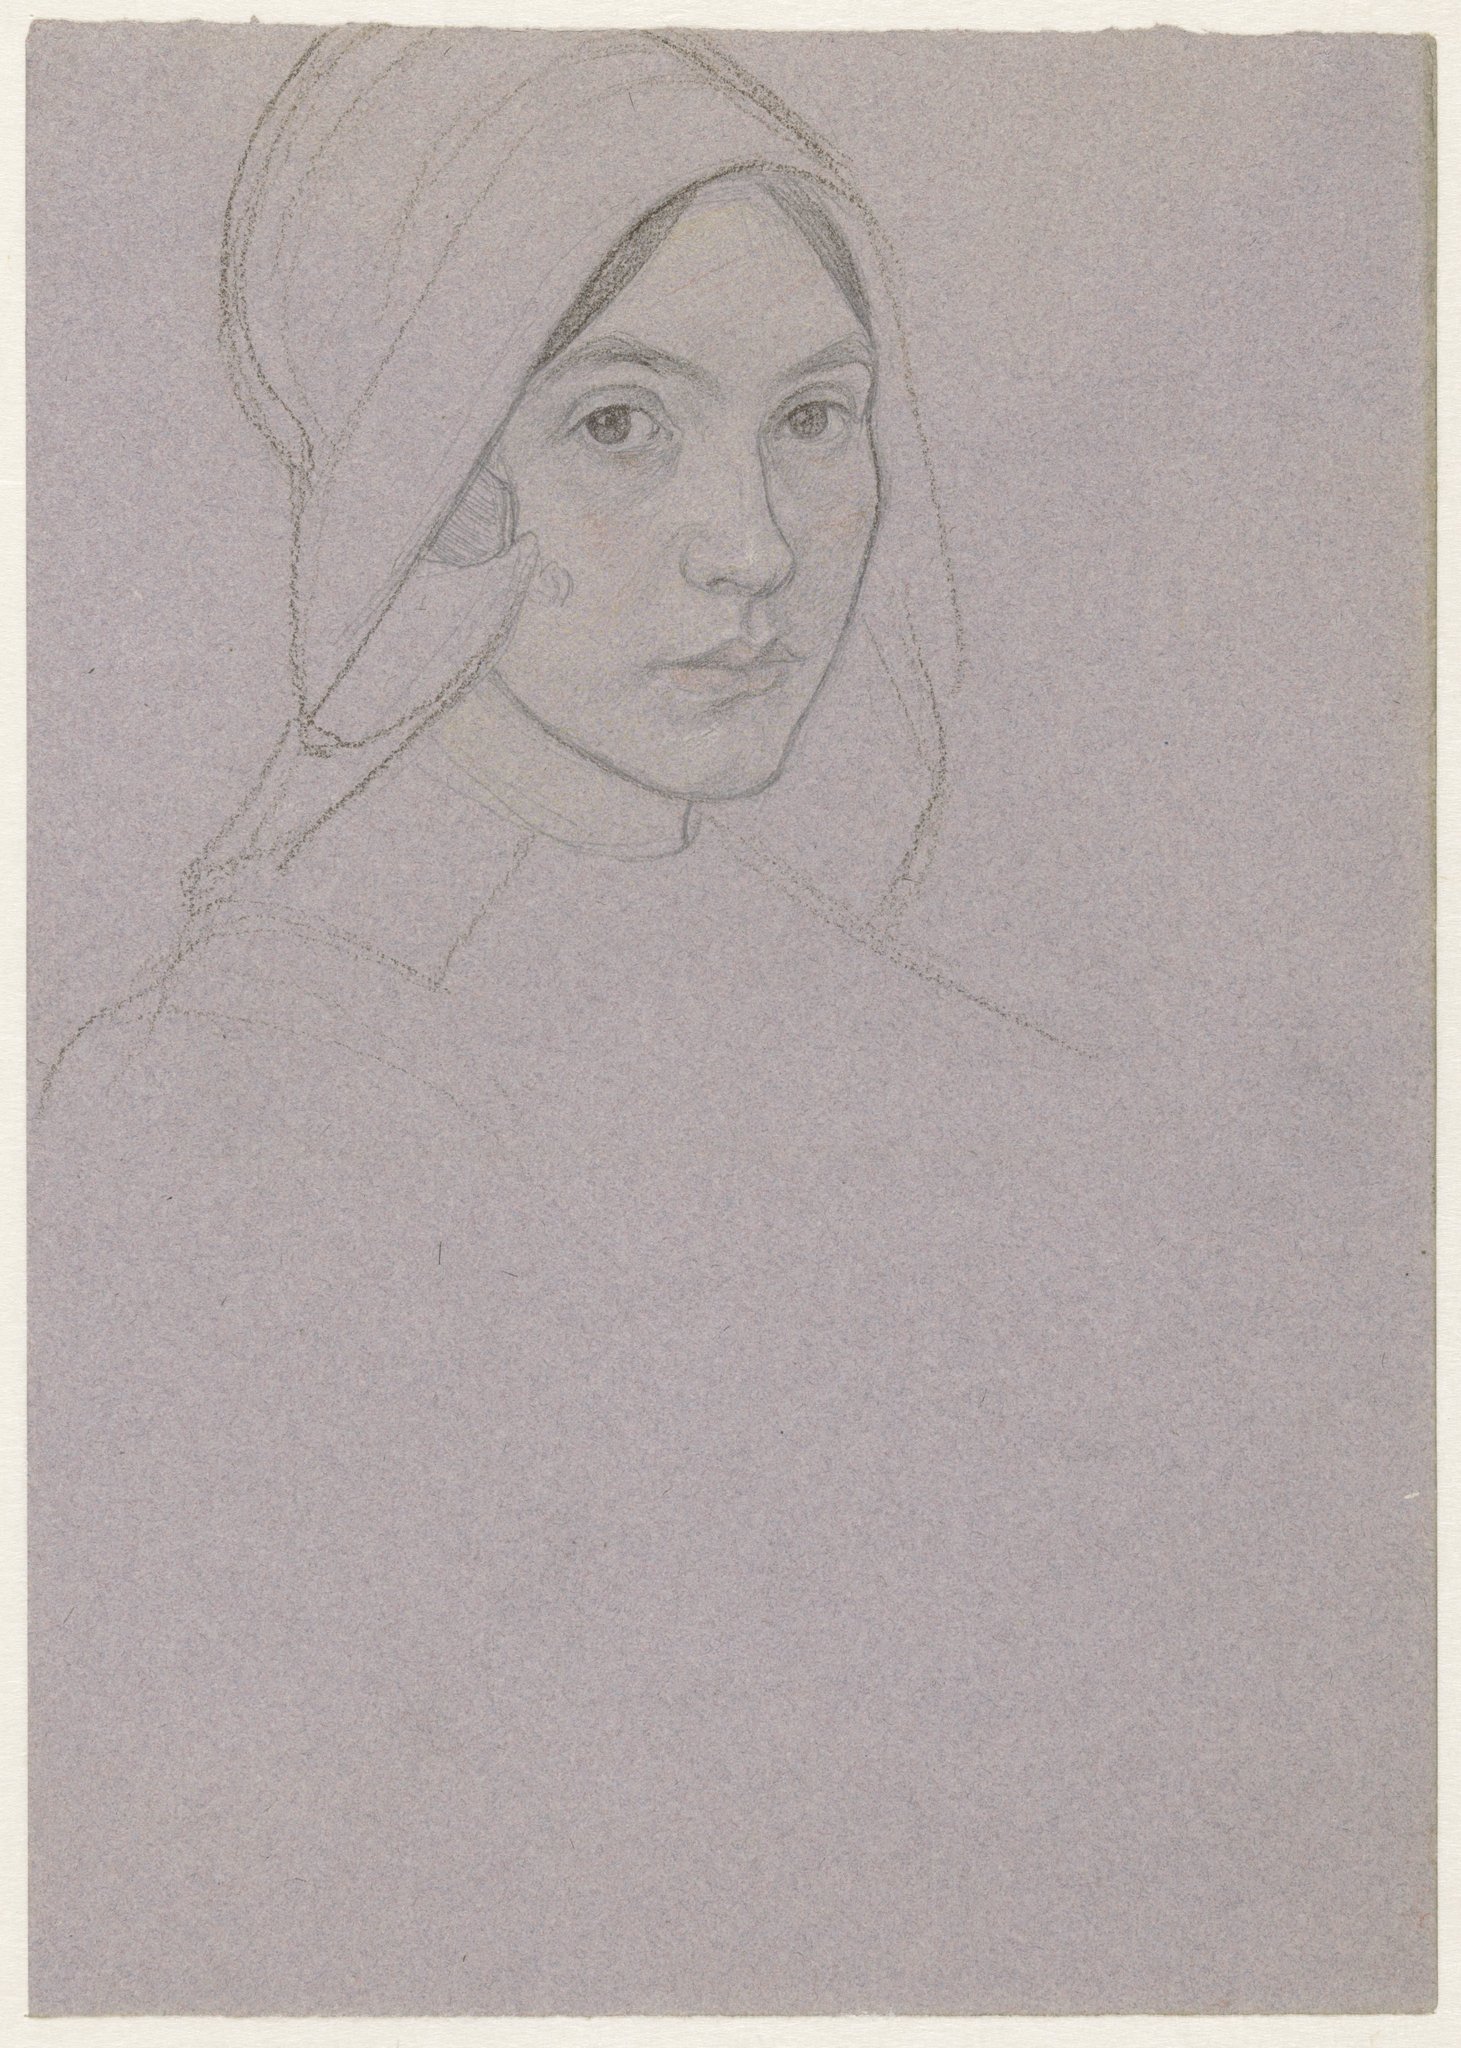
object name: drawing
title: Portret van een meisje met kap (Karen?)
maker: jan veth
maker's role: designer, draughtsman, painter, print maker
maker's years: 1864-1925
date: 1874-1925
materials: chalk, paper, pencil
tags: historical persons not known by name - bb - woman, head-gear: hat